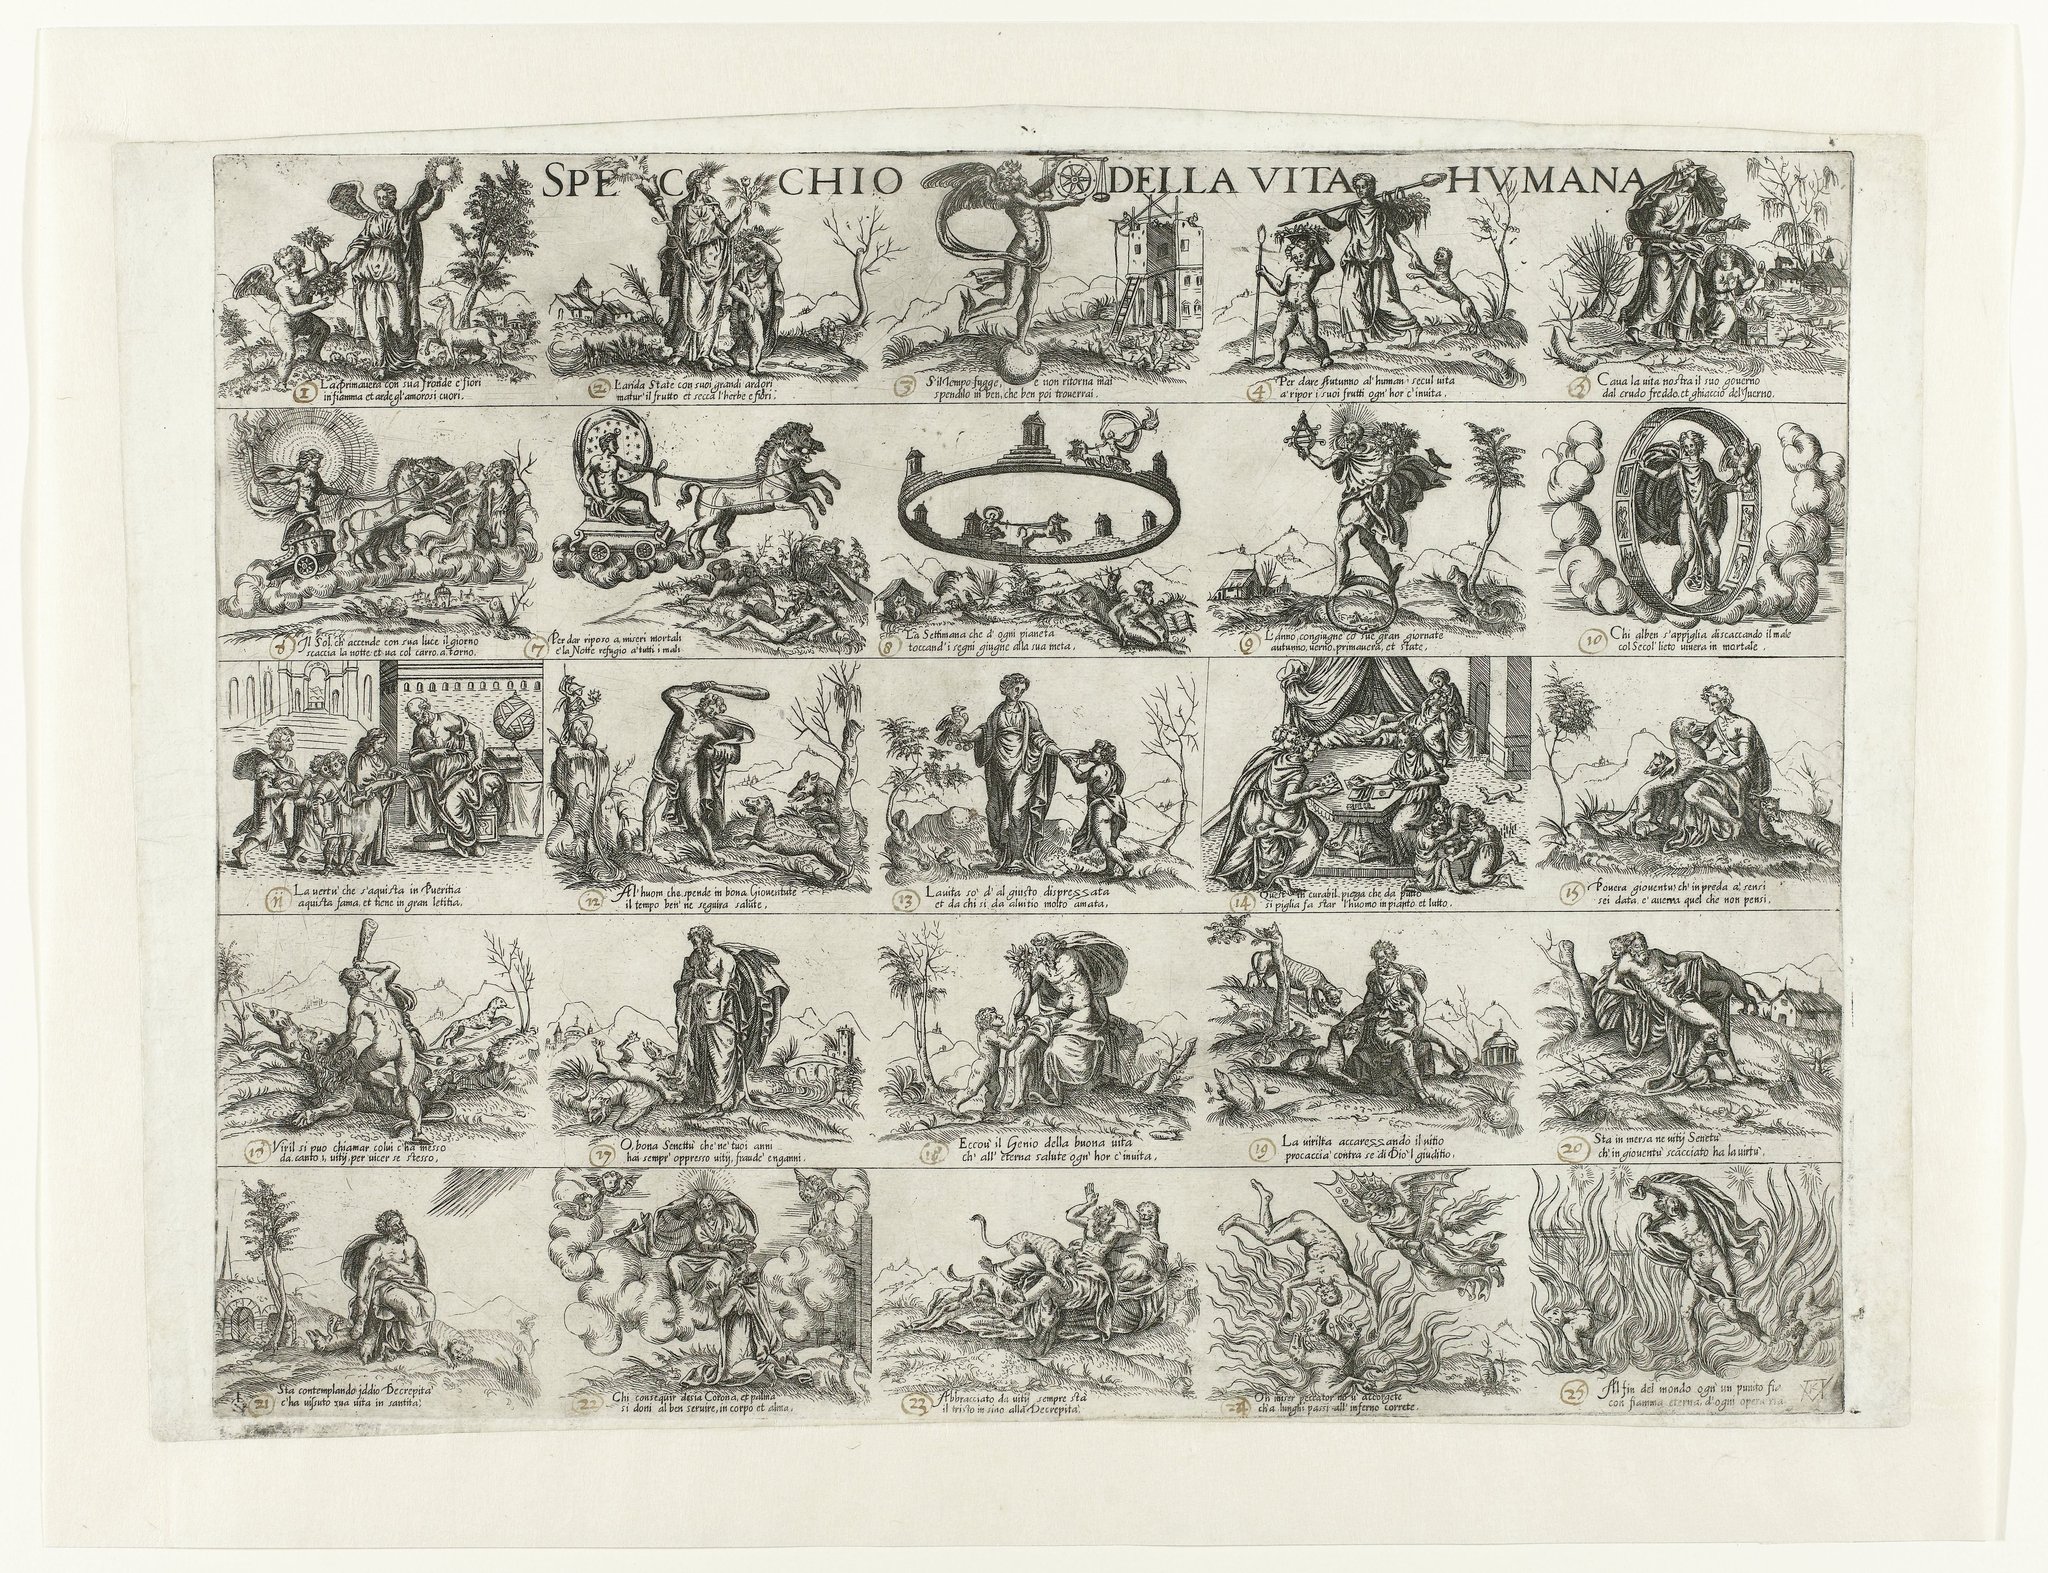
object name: print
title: Spiegel van het menselijk leven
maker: mario cartaro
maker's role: print maker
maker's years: 1560-1620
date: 1566-1570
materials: paper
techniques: engraving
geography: vatican city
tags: the course of life symbolized, the life of man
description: Naar het fresco-programma in de loggia op de derde etage van het pauselijk paleis te Rome, bedacht door Pirro Ligorio en uitgevoerd door respectievelijk Giovanni da Udine, Donato da Udine, Sabaoth en zijn atelier. de landschappelijke achtergronden zijn toegeschreven aan Etienne Duperac.